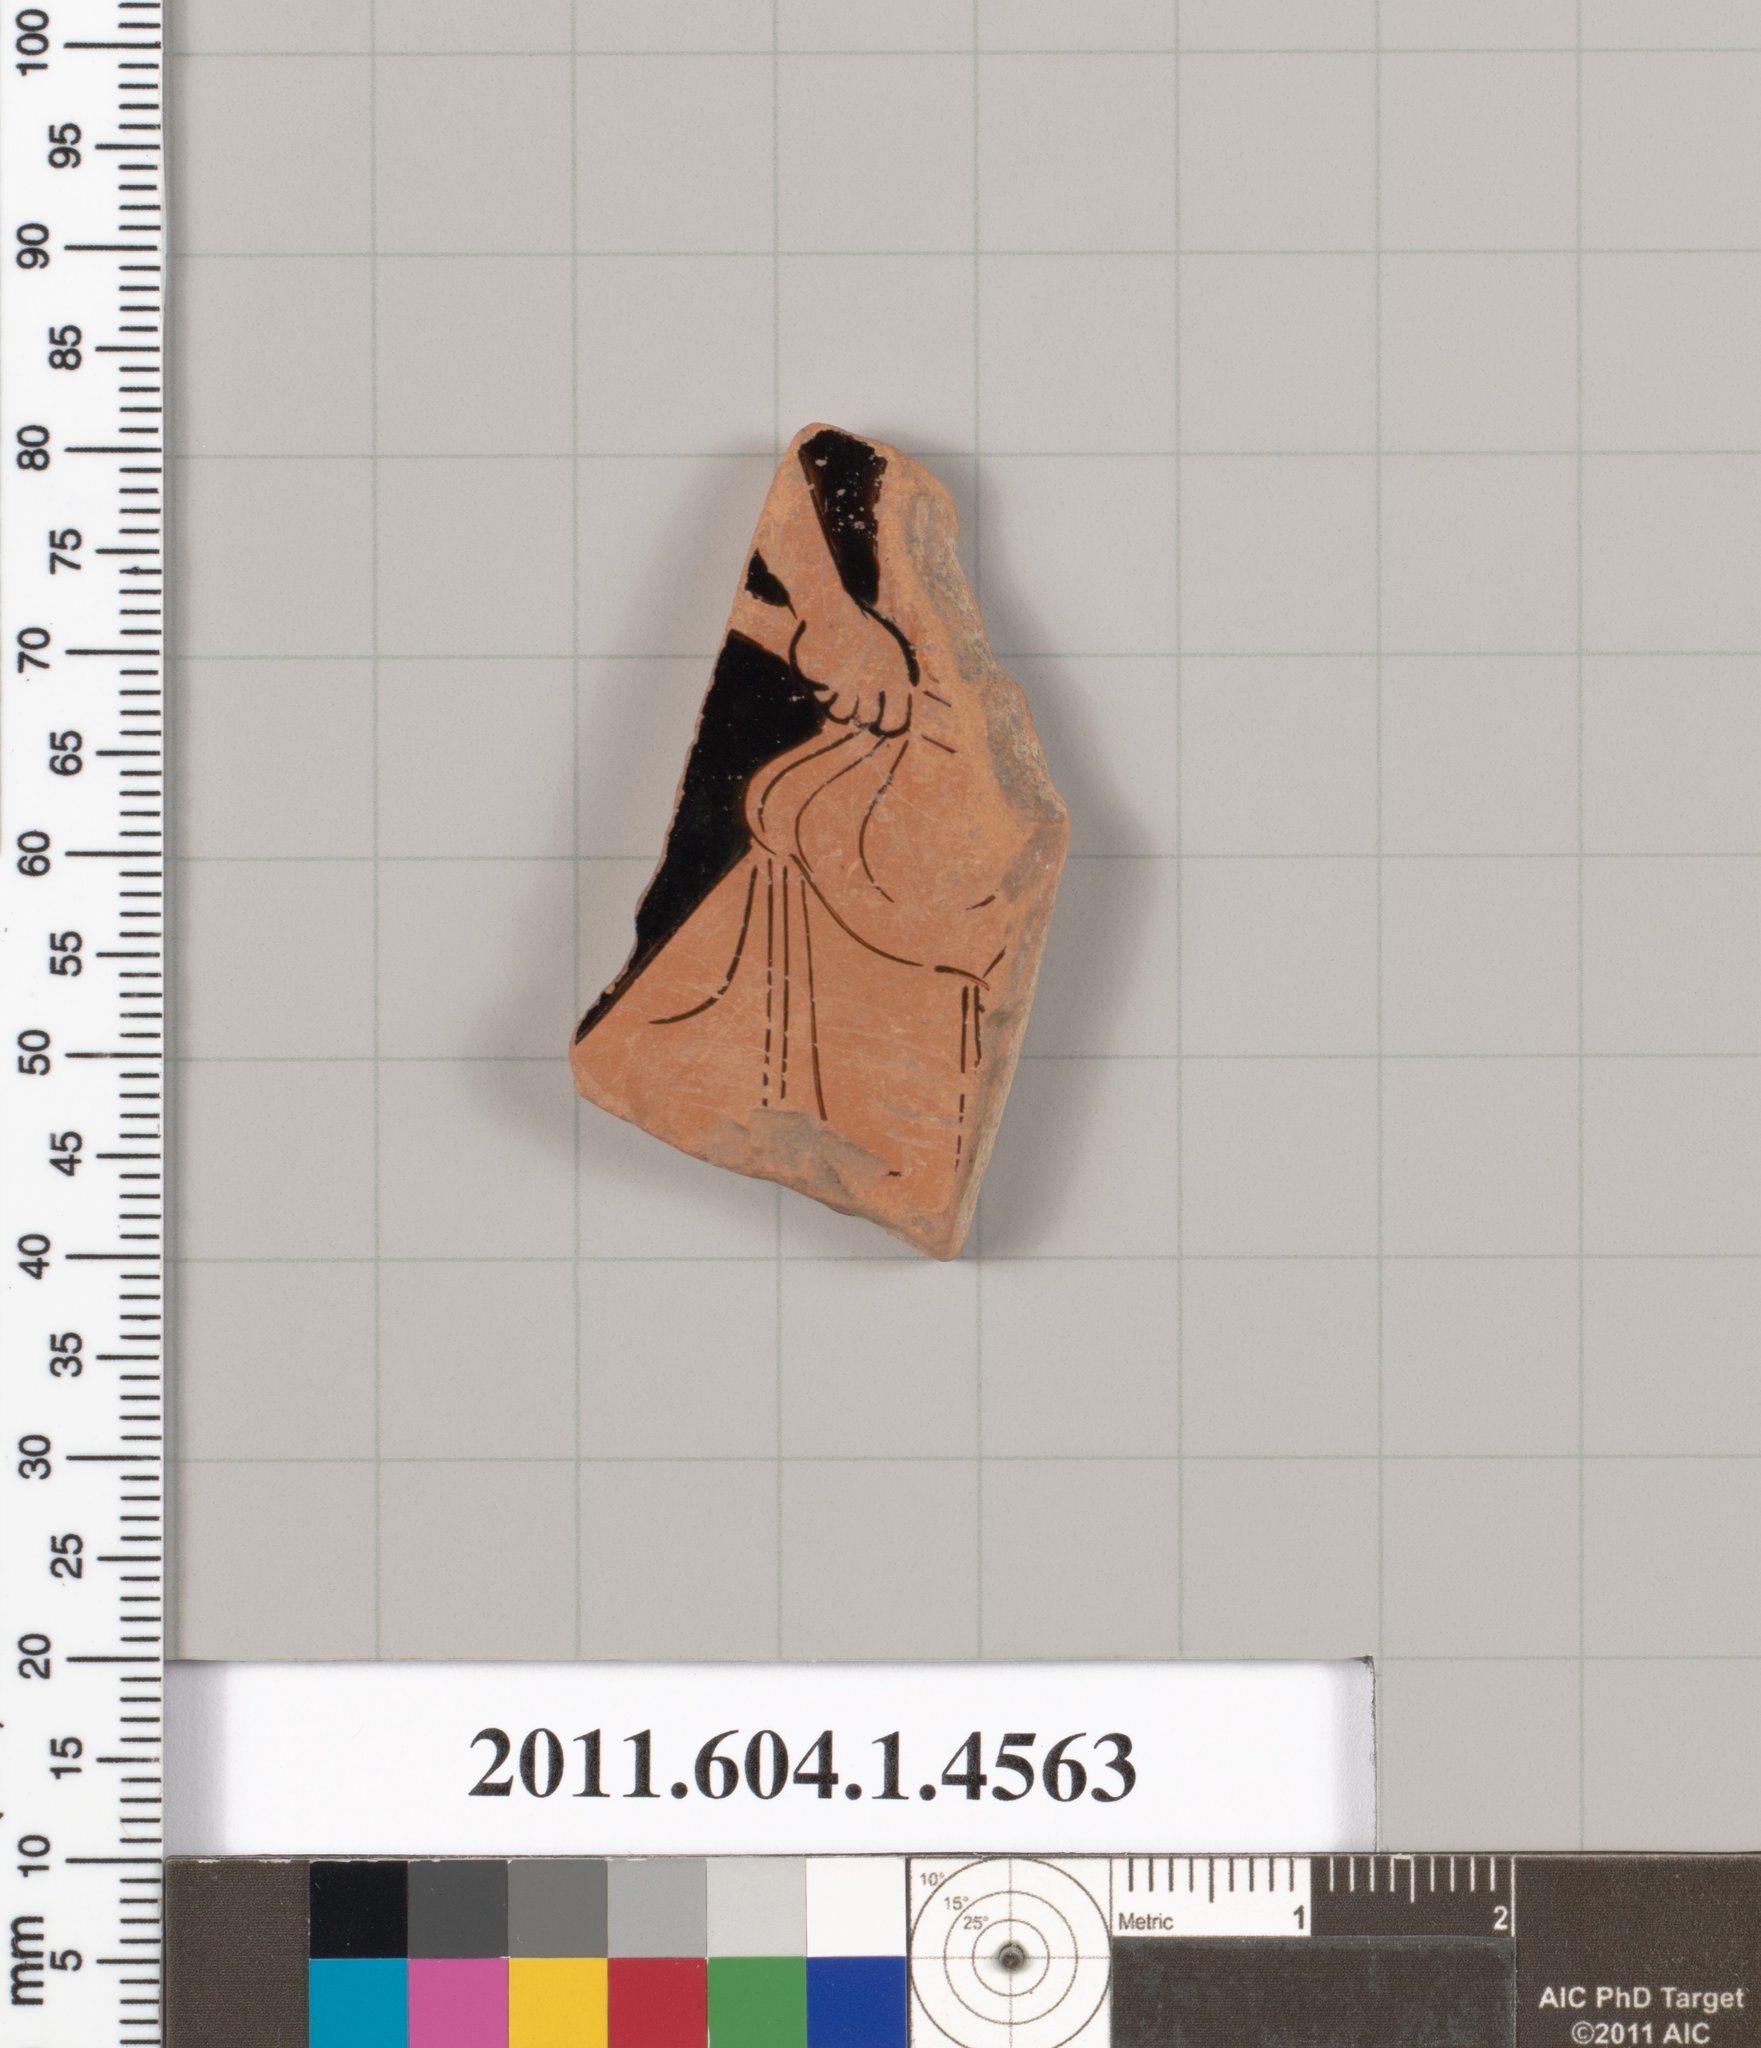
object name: kylix fragment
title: Terracotta fragment of a kylix (drinking cup)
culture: greek, attic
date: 480-470 BCE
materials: terracotta